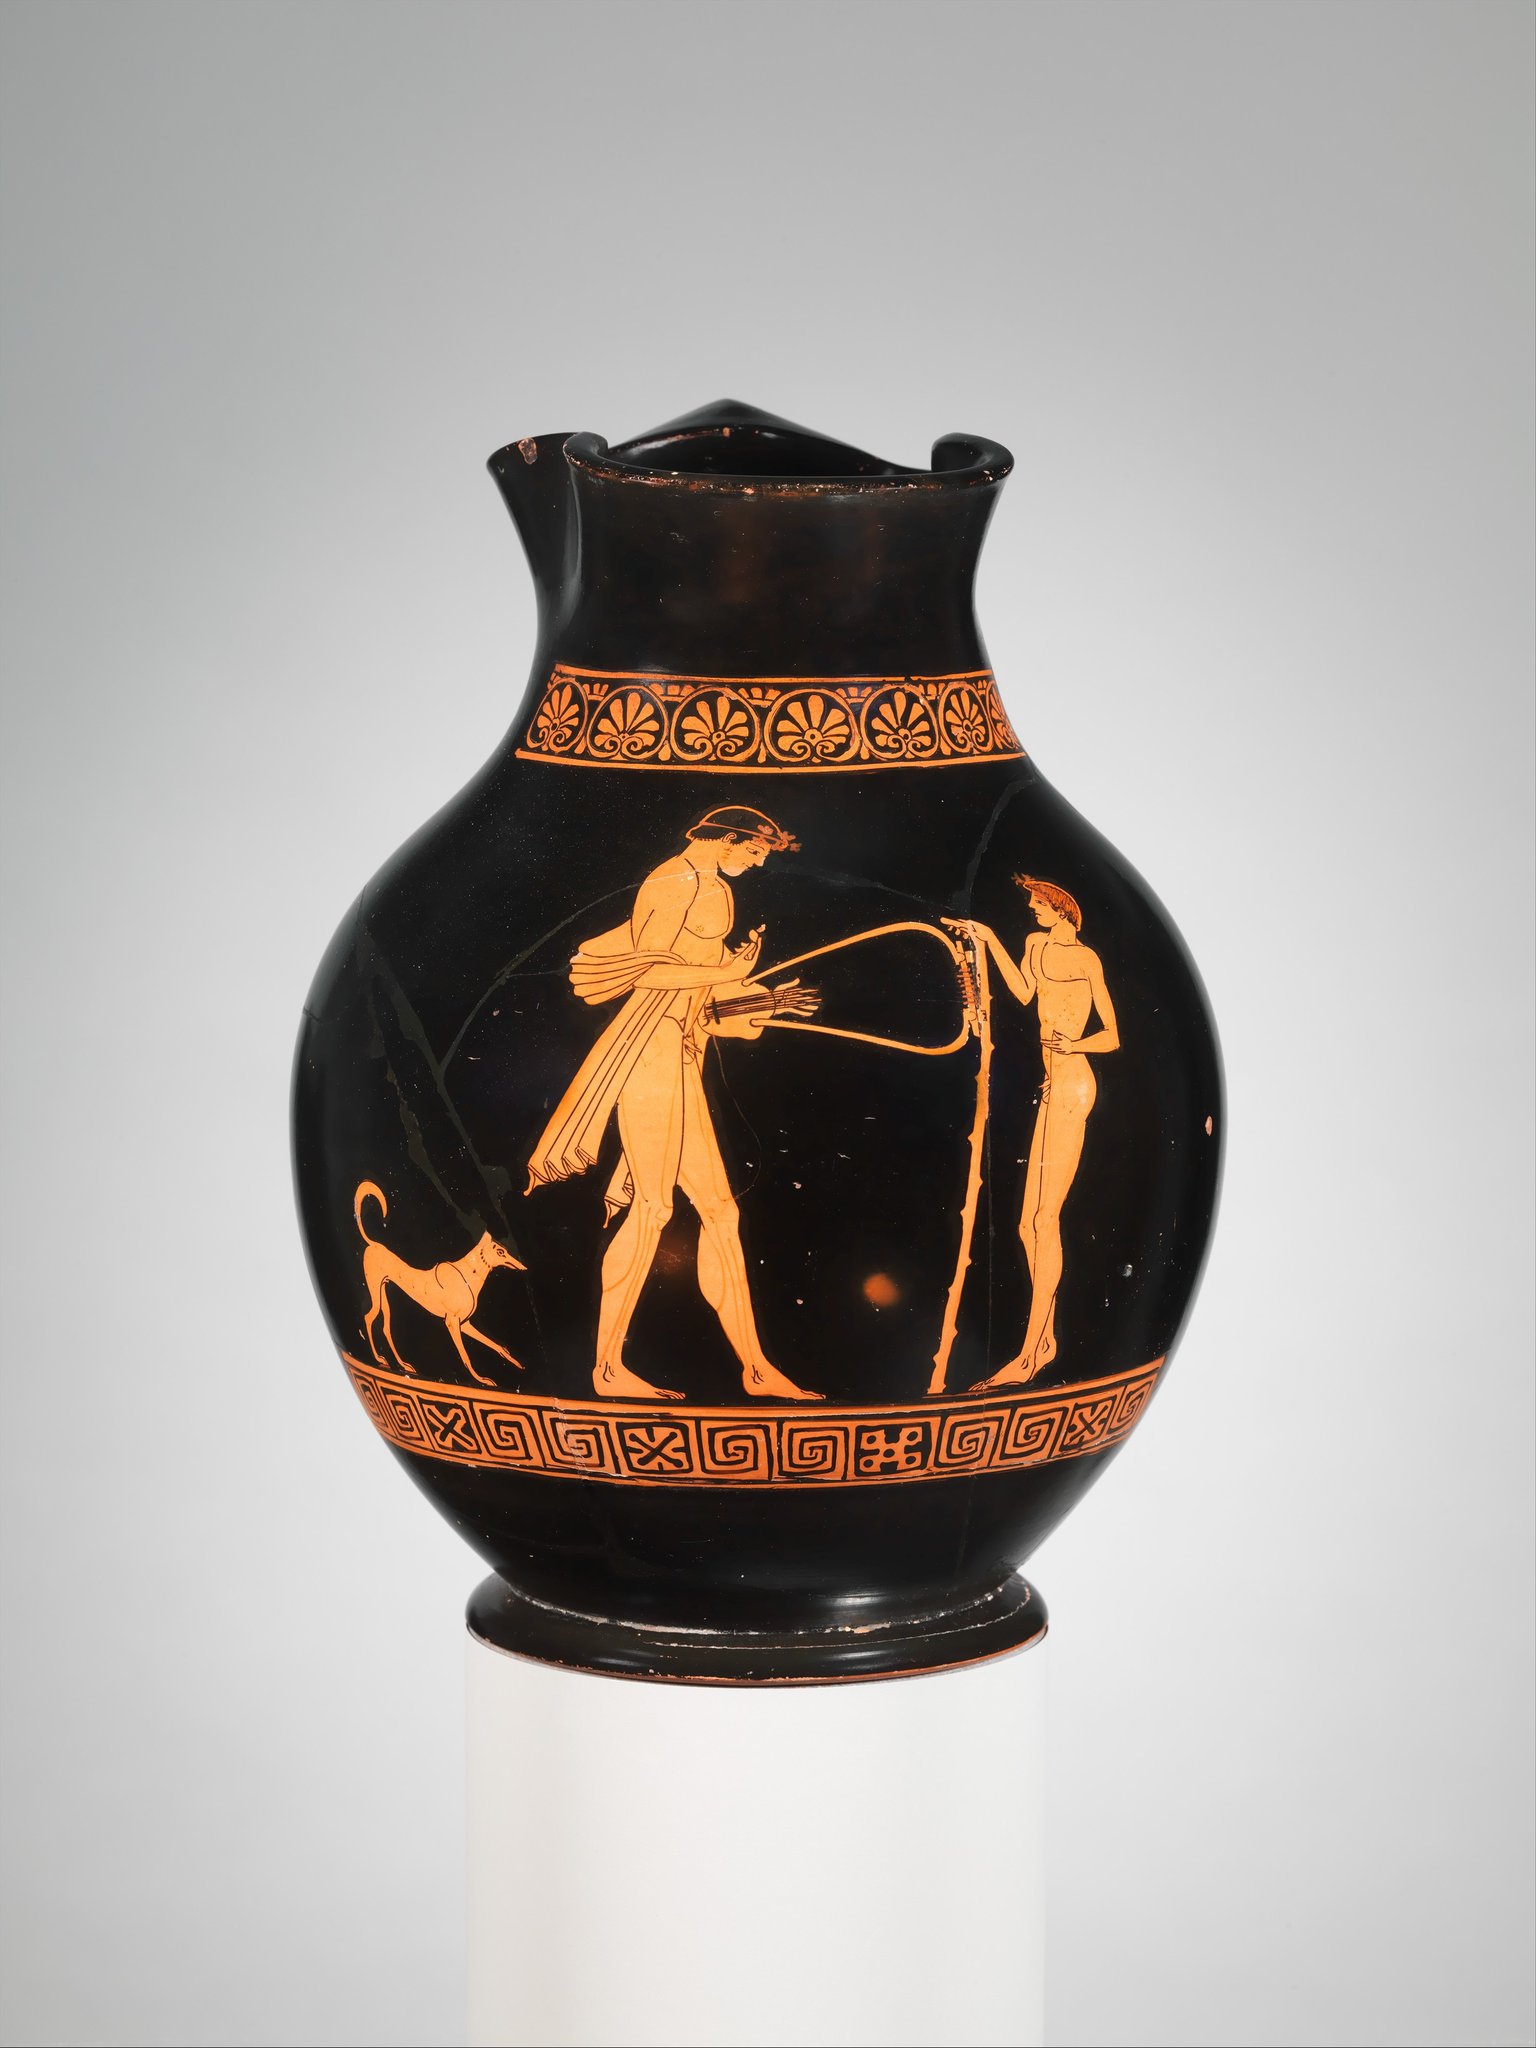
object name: oinochoe, chou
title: Terracotta oinochoe: chous (jug)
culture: greek, attic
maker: berlin painter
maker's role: artist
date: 490-480 BCE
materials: terracotta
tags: boys,male nudes,dogs,lyres